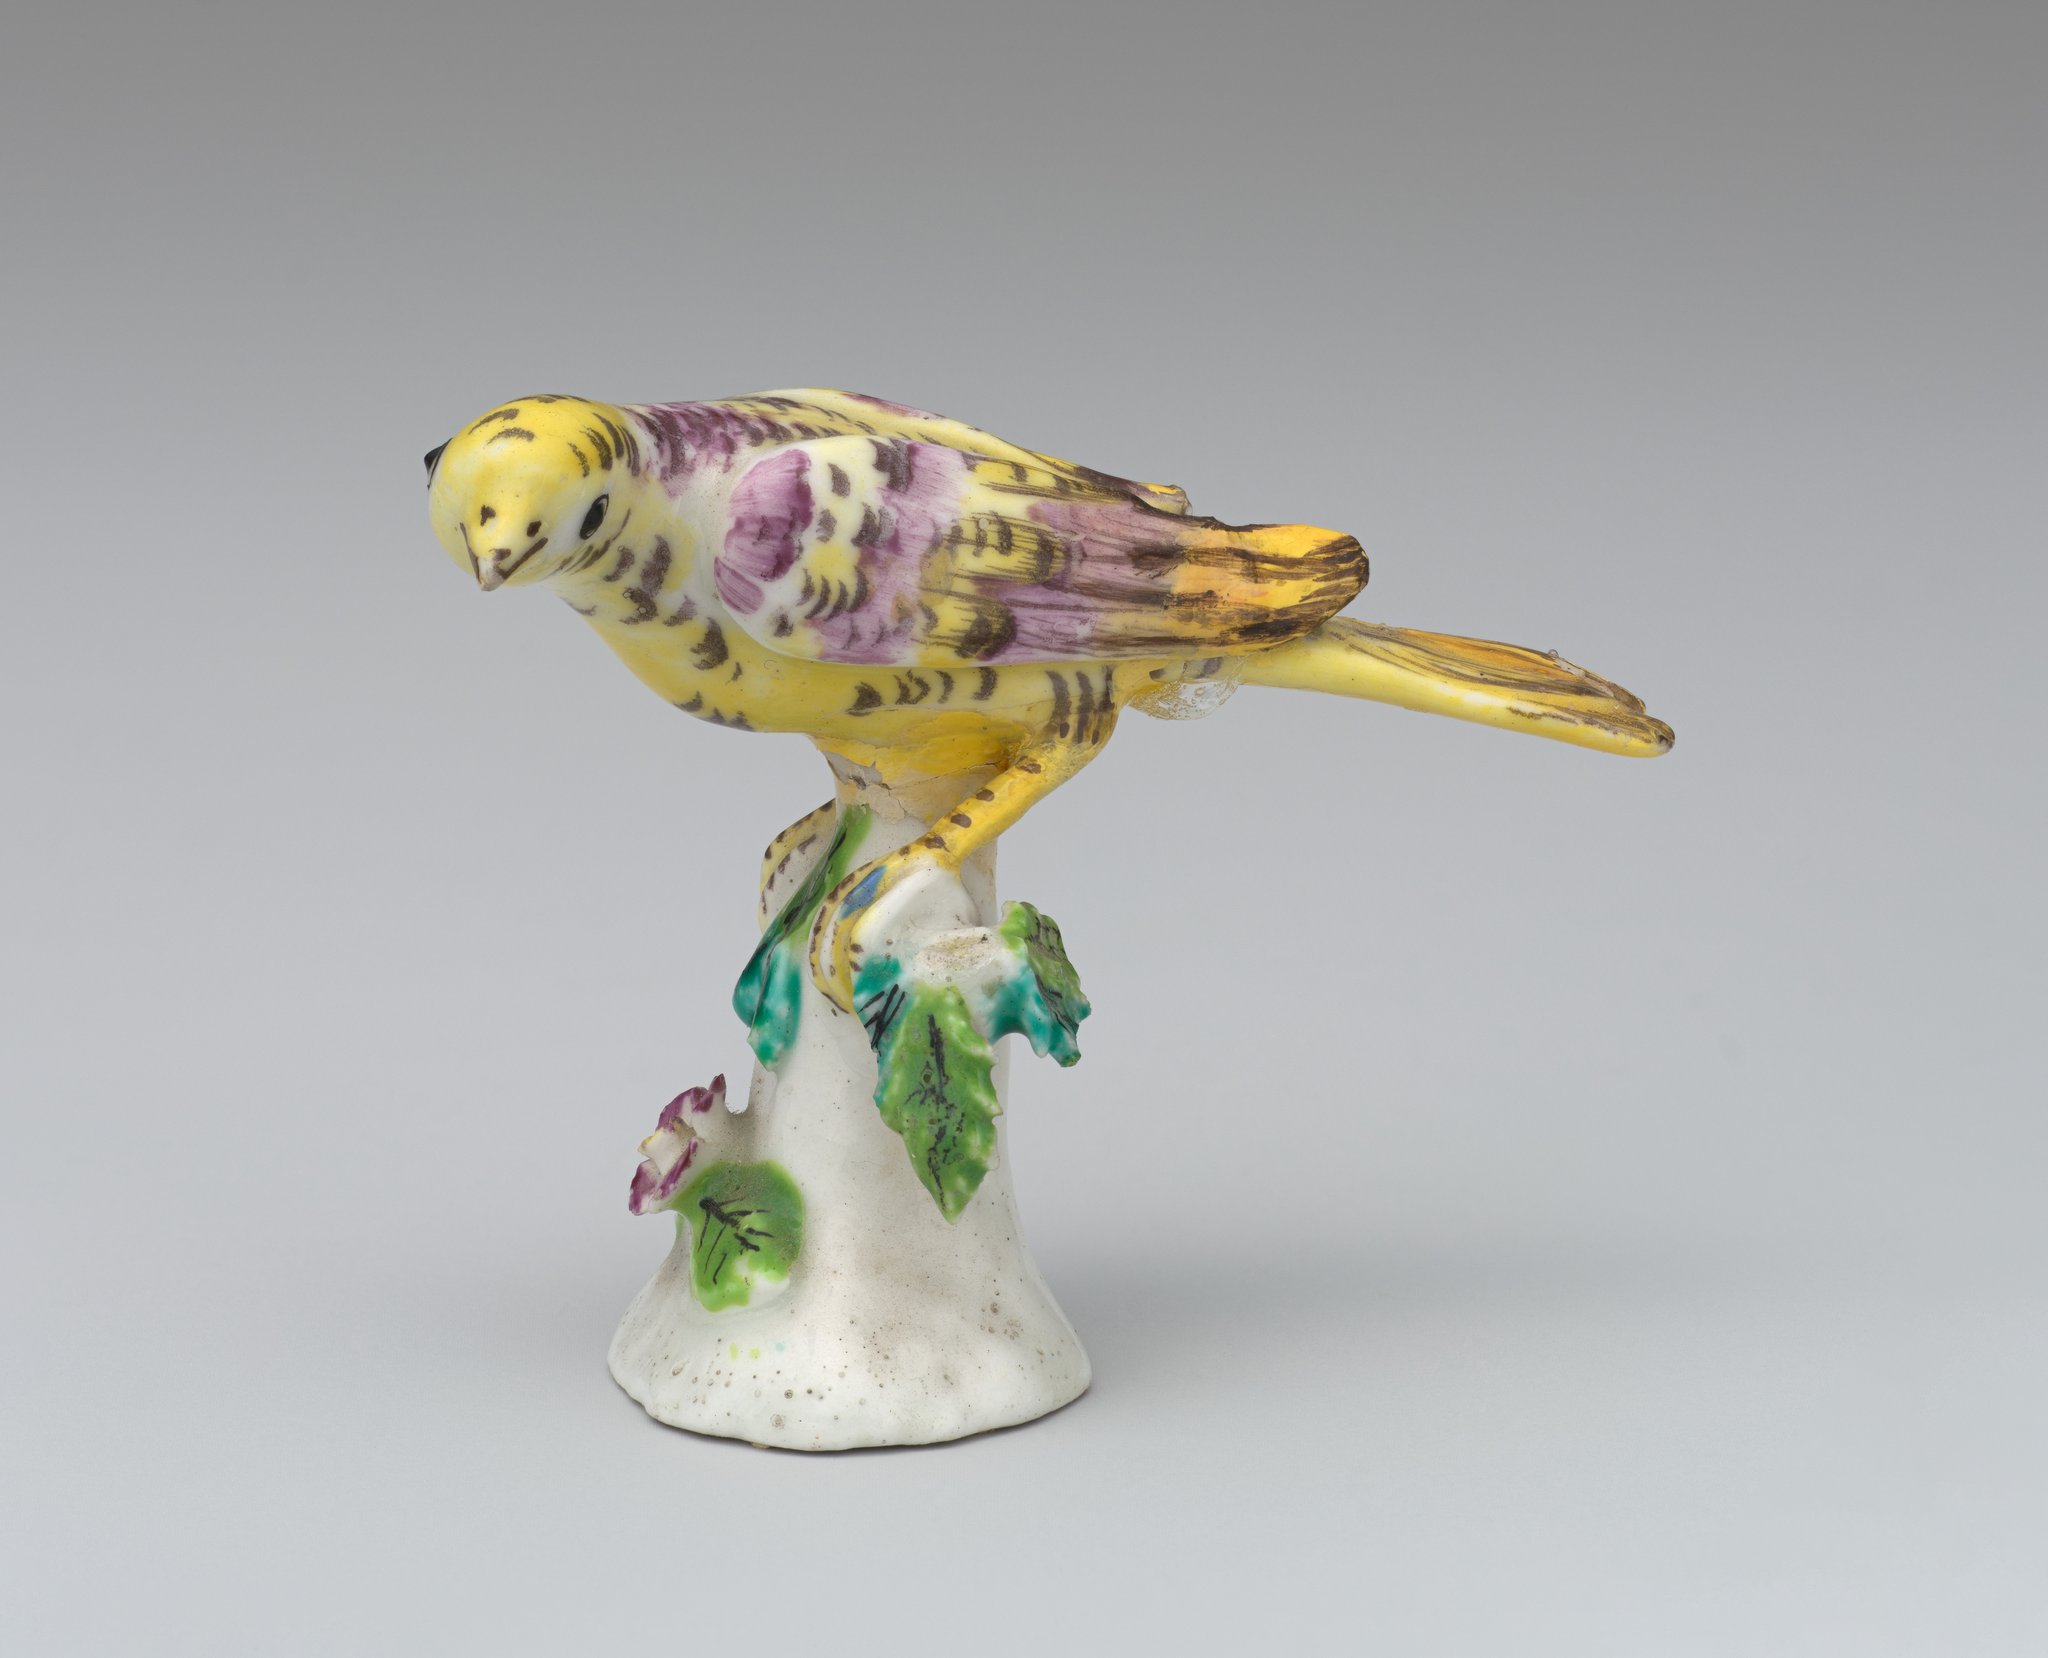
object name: figure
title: Bunting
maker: bow porcelain factory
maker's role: factory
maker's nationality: british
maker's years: 1747-1776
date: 1760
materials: soft paste porcelain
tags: birds